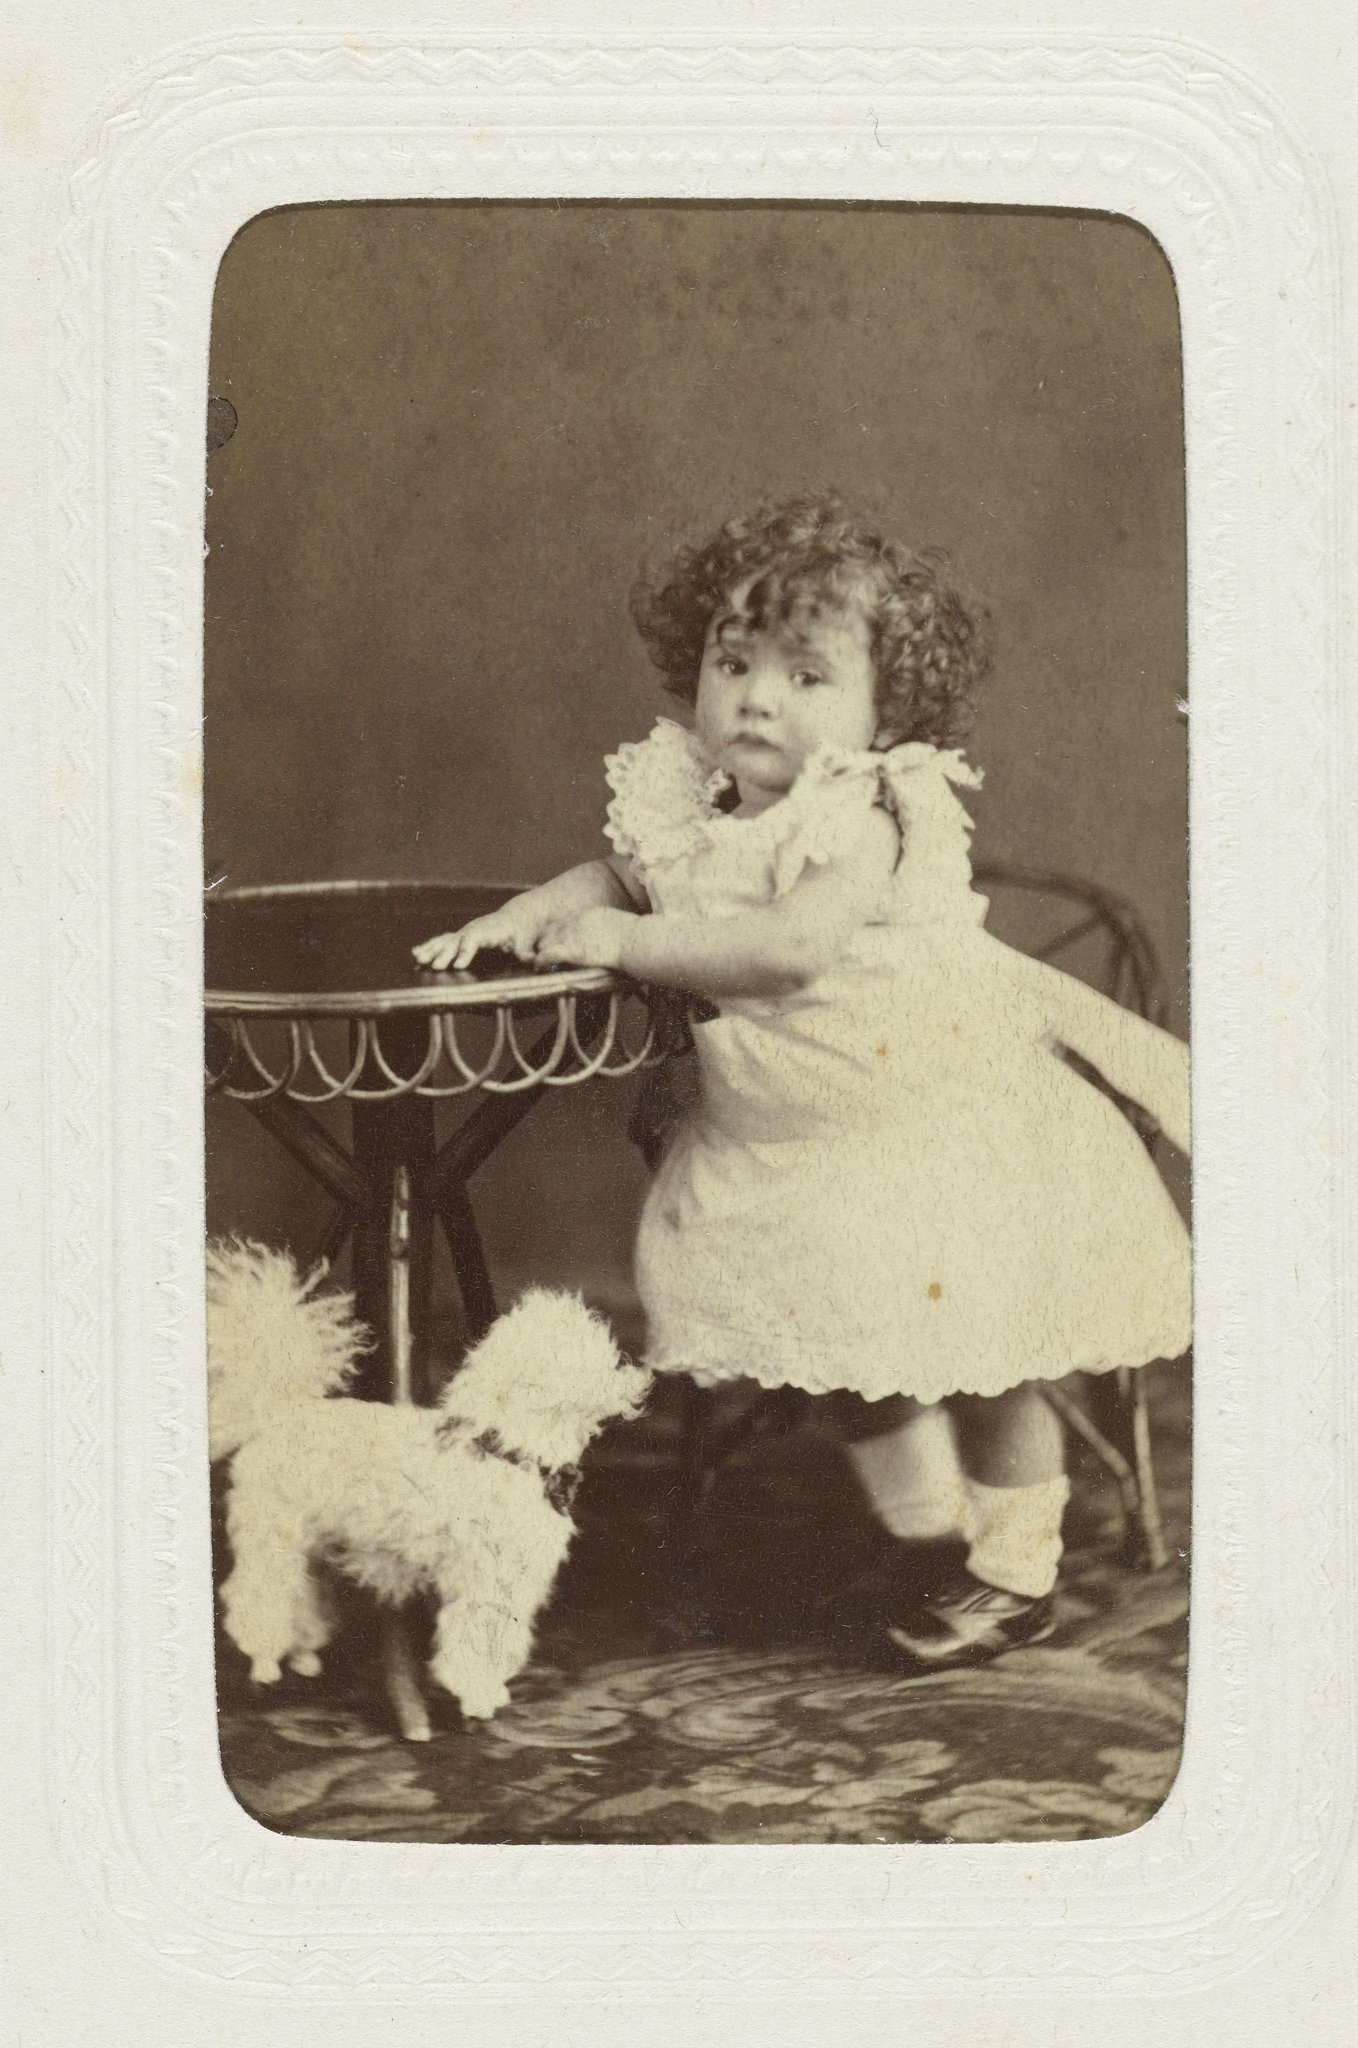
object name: carte de visite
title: Studioportret van een klein meisje met een speelgoed hondje bij een tafel.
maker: maurits verveer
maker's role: painter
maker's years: 1817-1903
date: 1863-1866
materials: cardboard, paper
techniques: albumen print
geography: the hague